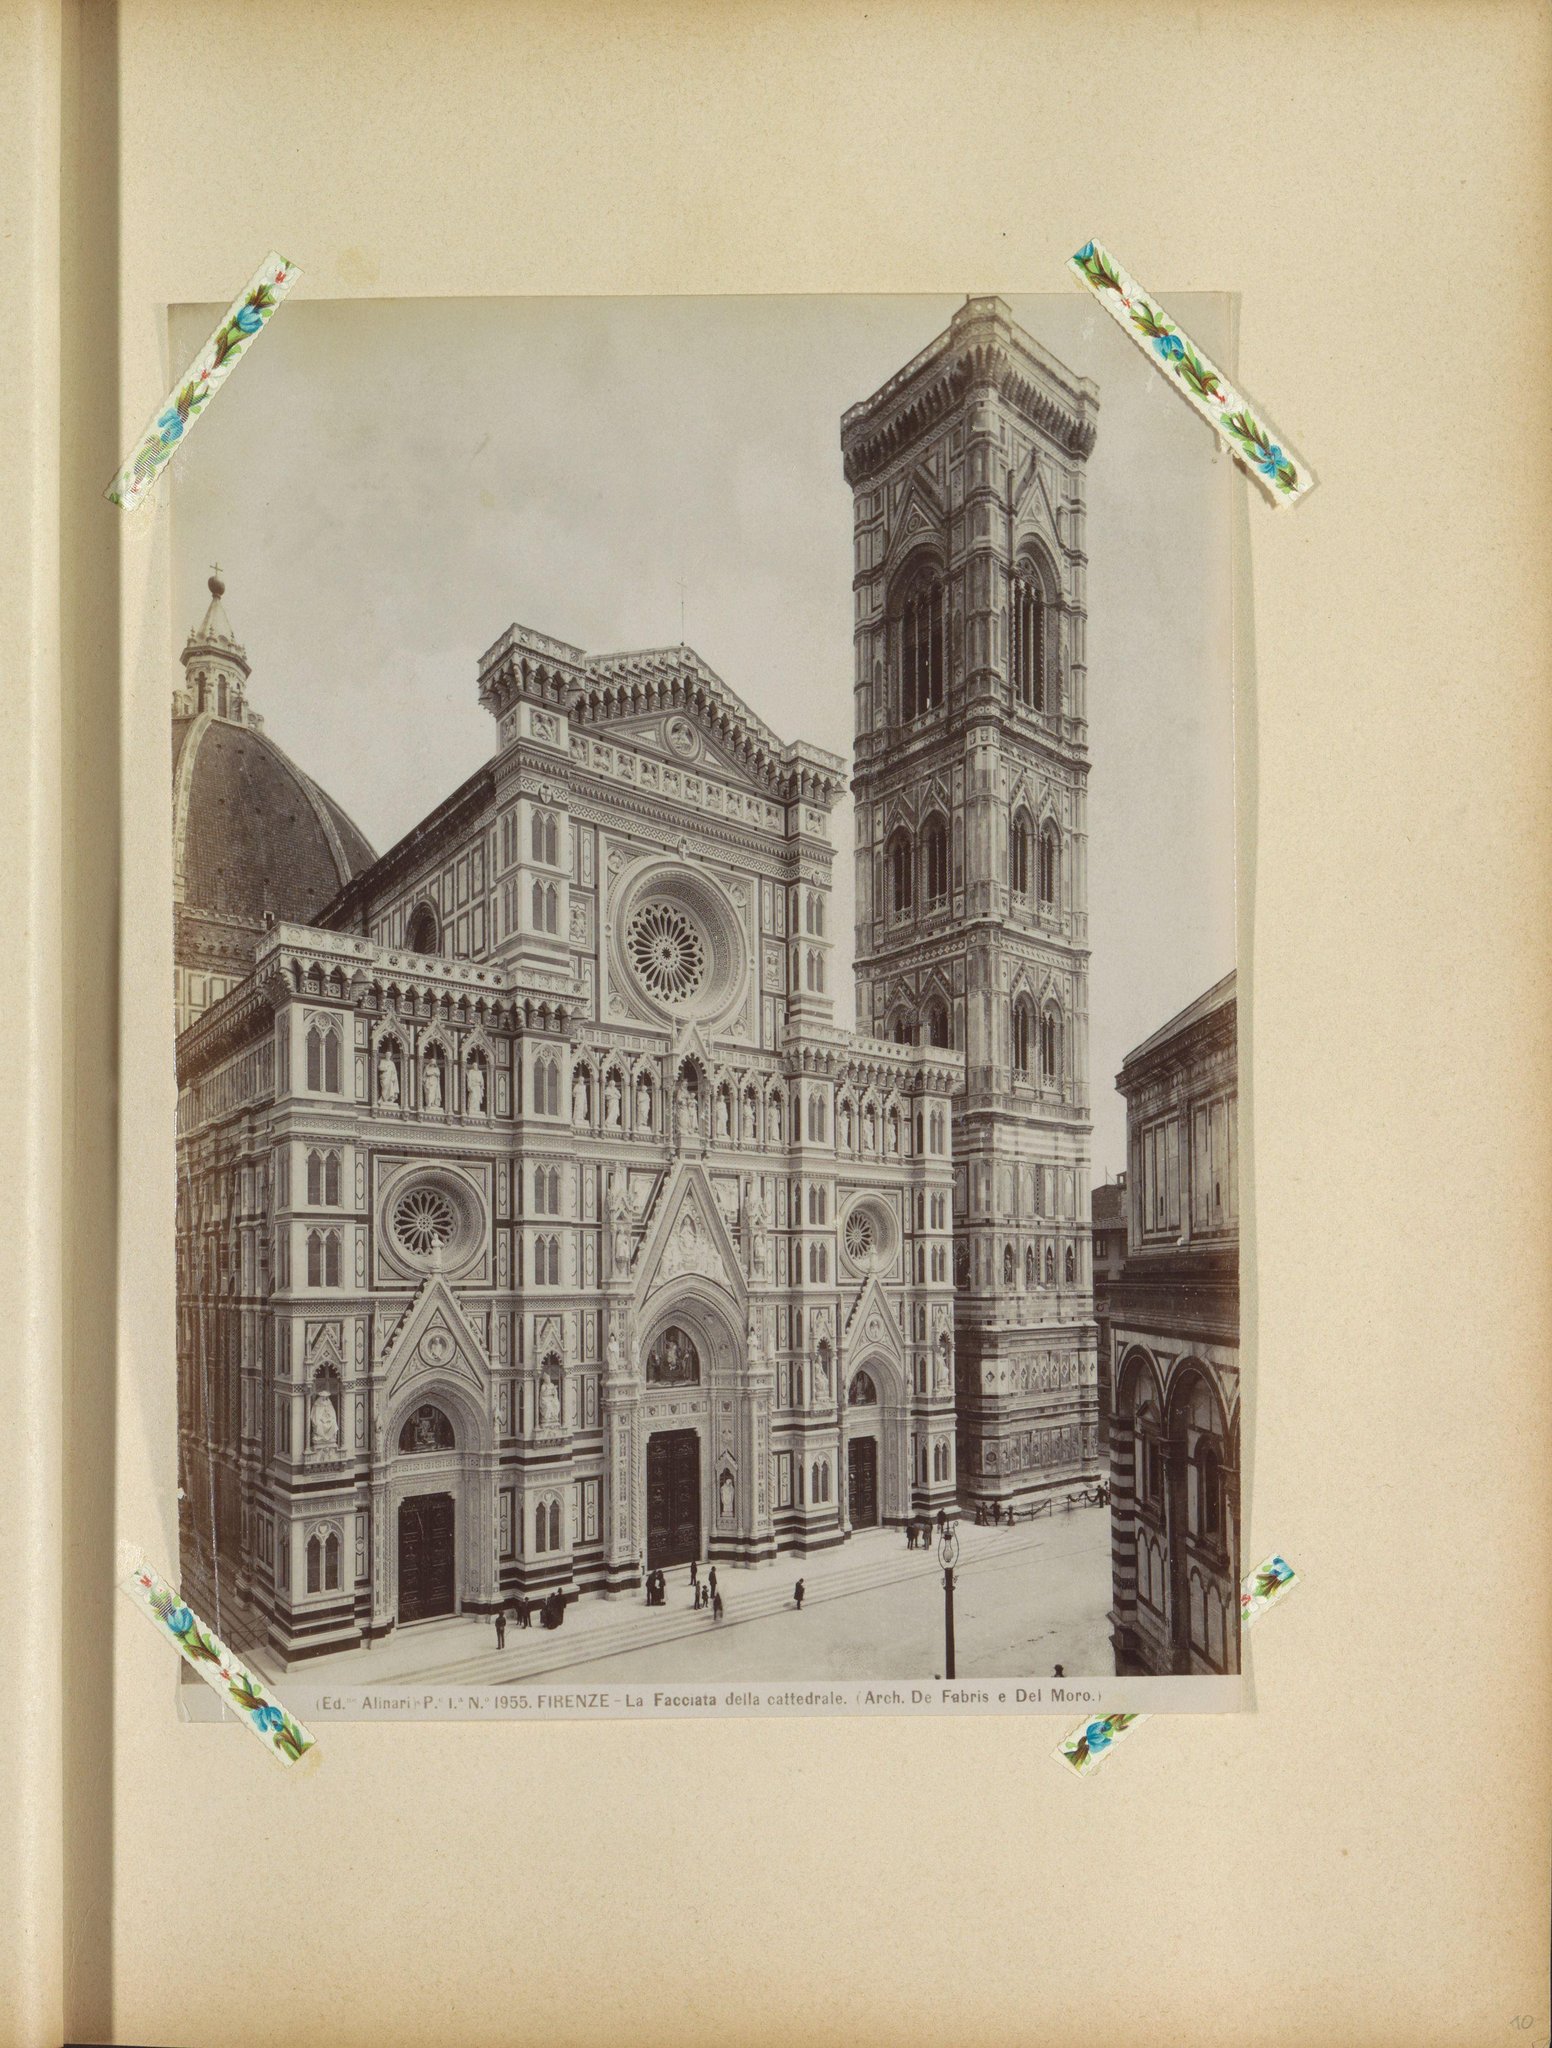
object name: photograph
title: Firenze - La Facciata della cattedrale. (Arch. De Fabris e Del Moro)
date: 1860-1900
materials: photographic support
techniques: albumen print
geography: florence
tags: parts of church exterior and annexes: campanile, church (exterior)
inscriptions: number: ‘P.e.1.a No. 1955’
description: Onderdeel van Fotoalbum met opnames van bezienswaardigheden in Italiaanse steden en van kunstwerken.